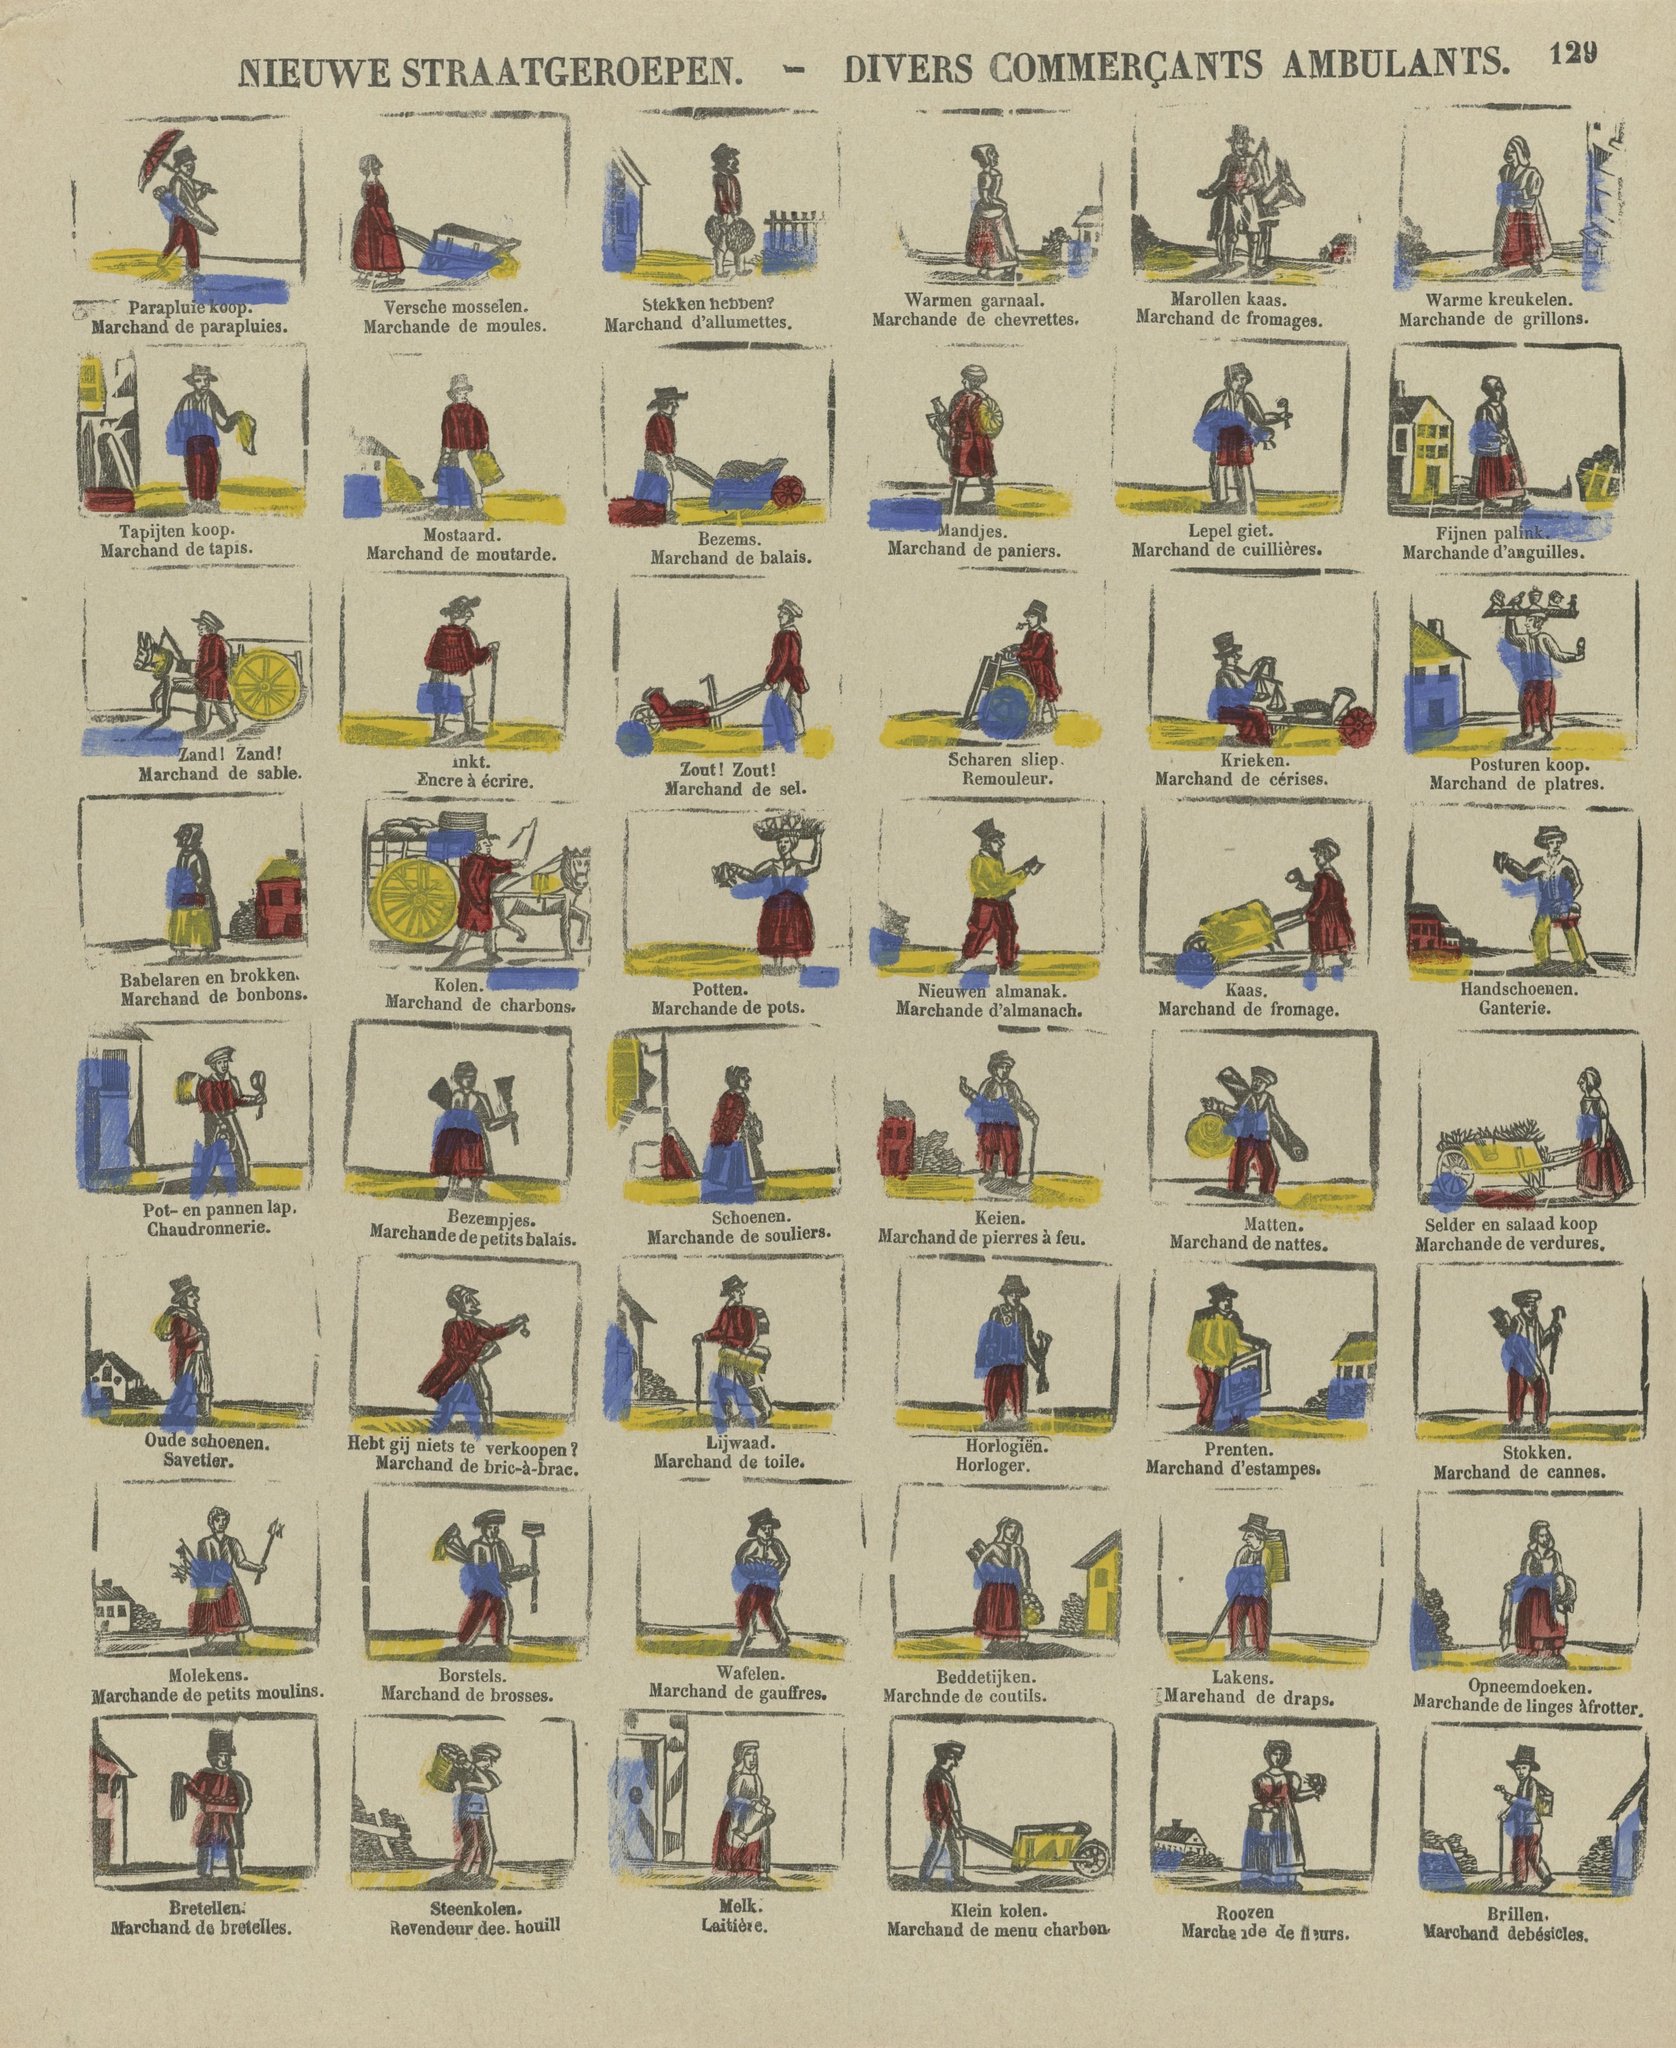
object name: print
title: Nieuwe straatgeroepen / Divers commerçants ambulants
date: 1800-1833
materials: paper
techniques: colour, letterpress printing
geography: turnhout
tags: street-trader, merchant, salesman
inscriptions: collector's mark: Lugt 2760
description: Blad met 48 voorstellingen van straatverkopers. Onder elke afbeelding een onderschrift in het Nederlands en in het Frans. Genummerd rechtsboven: 129.